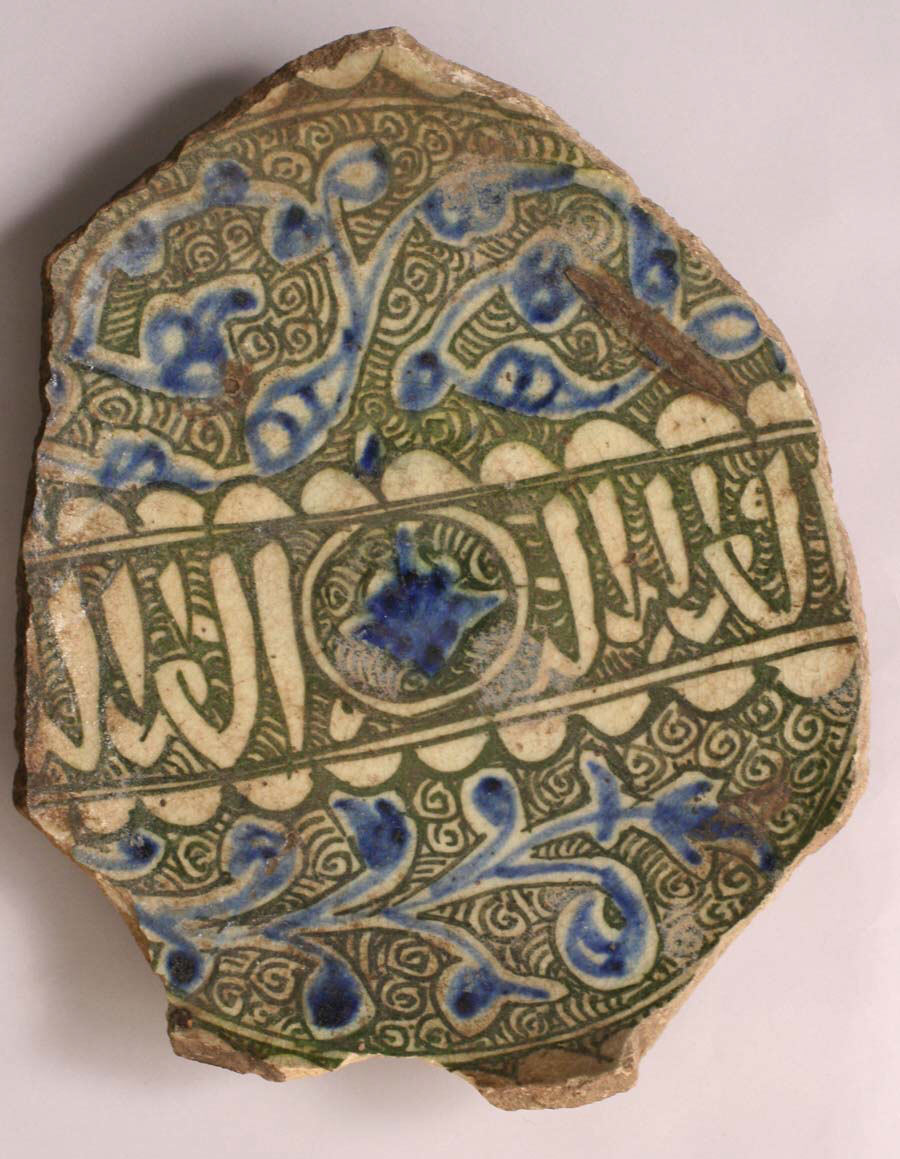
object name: fragment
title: Fragment of a Bowl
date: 1301-1400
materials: glaze, stonepaste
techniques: underglaze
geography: syria